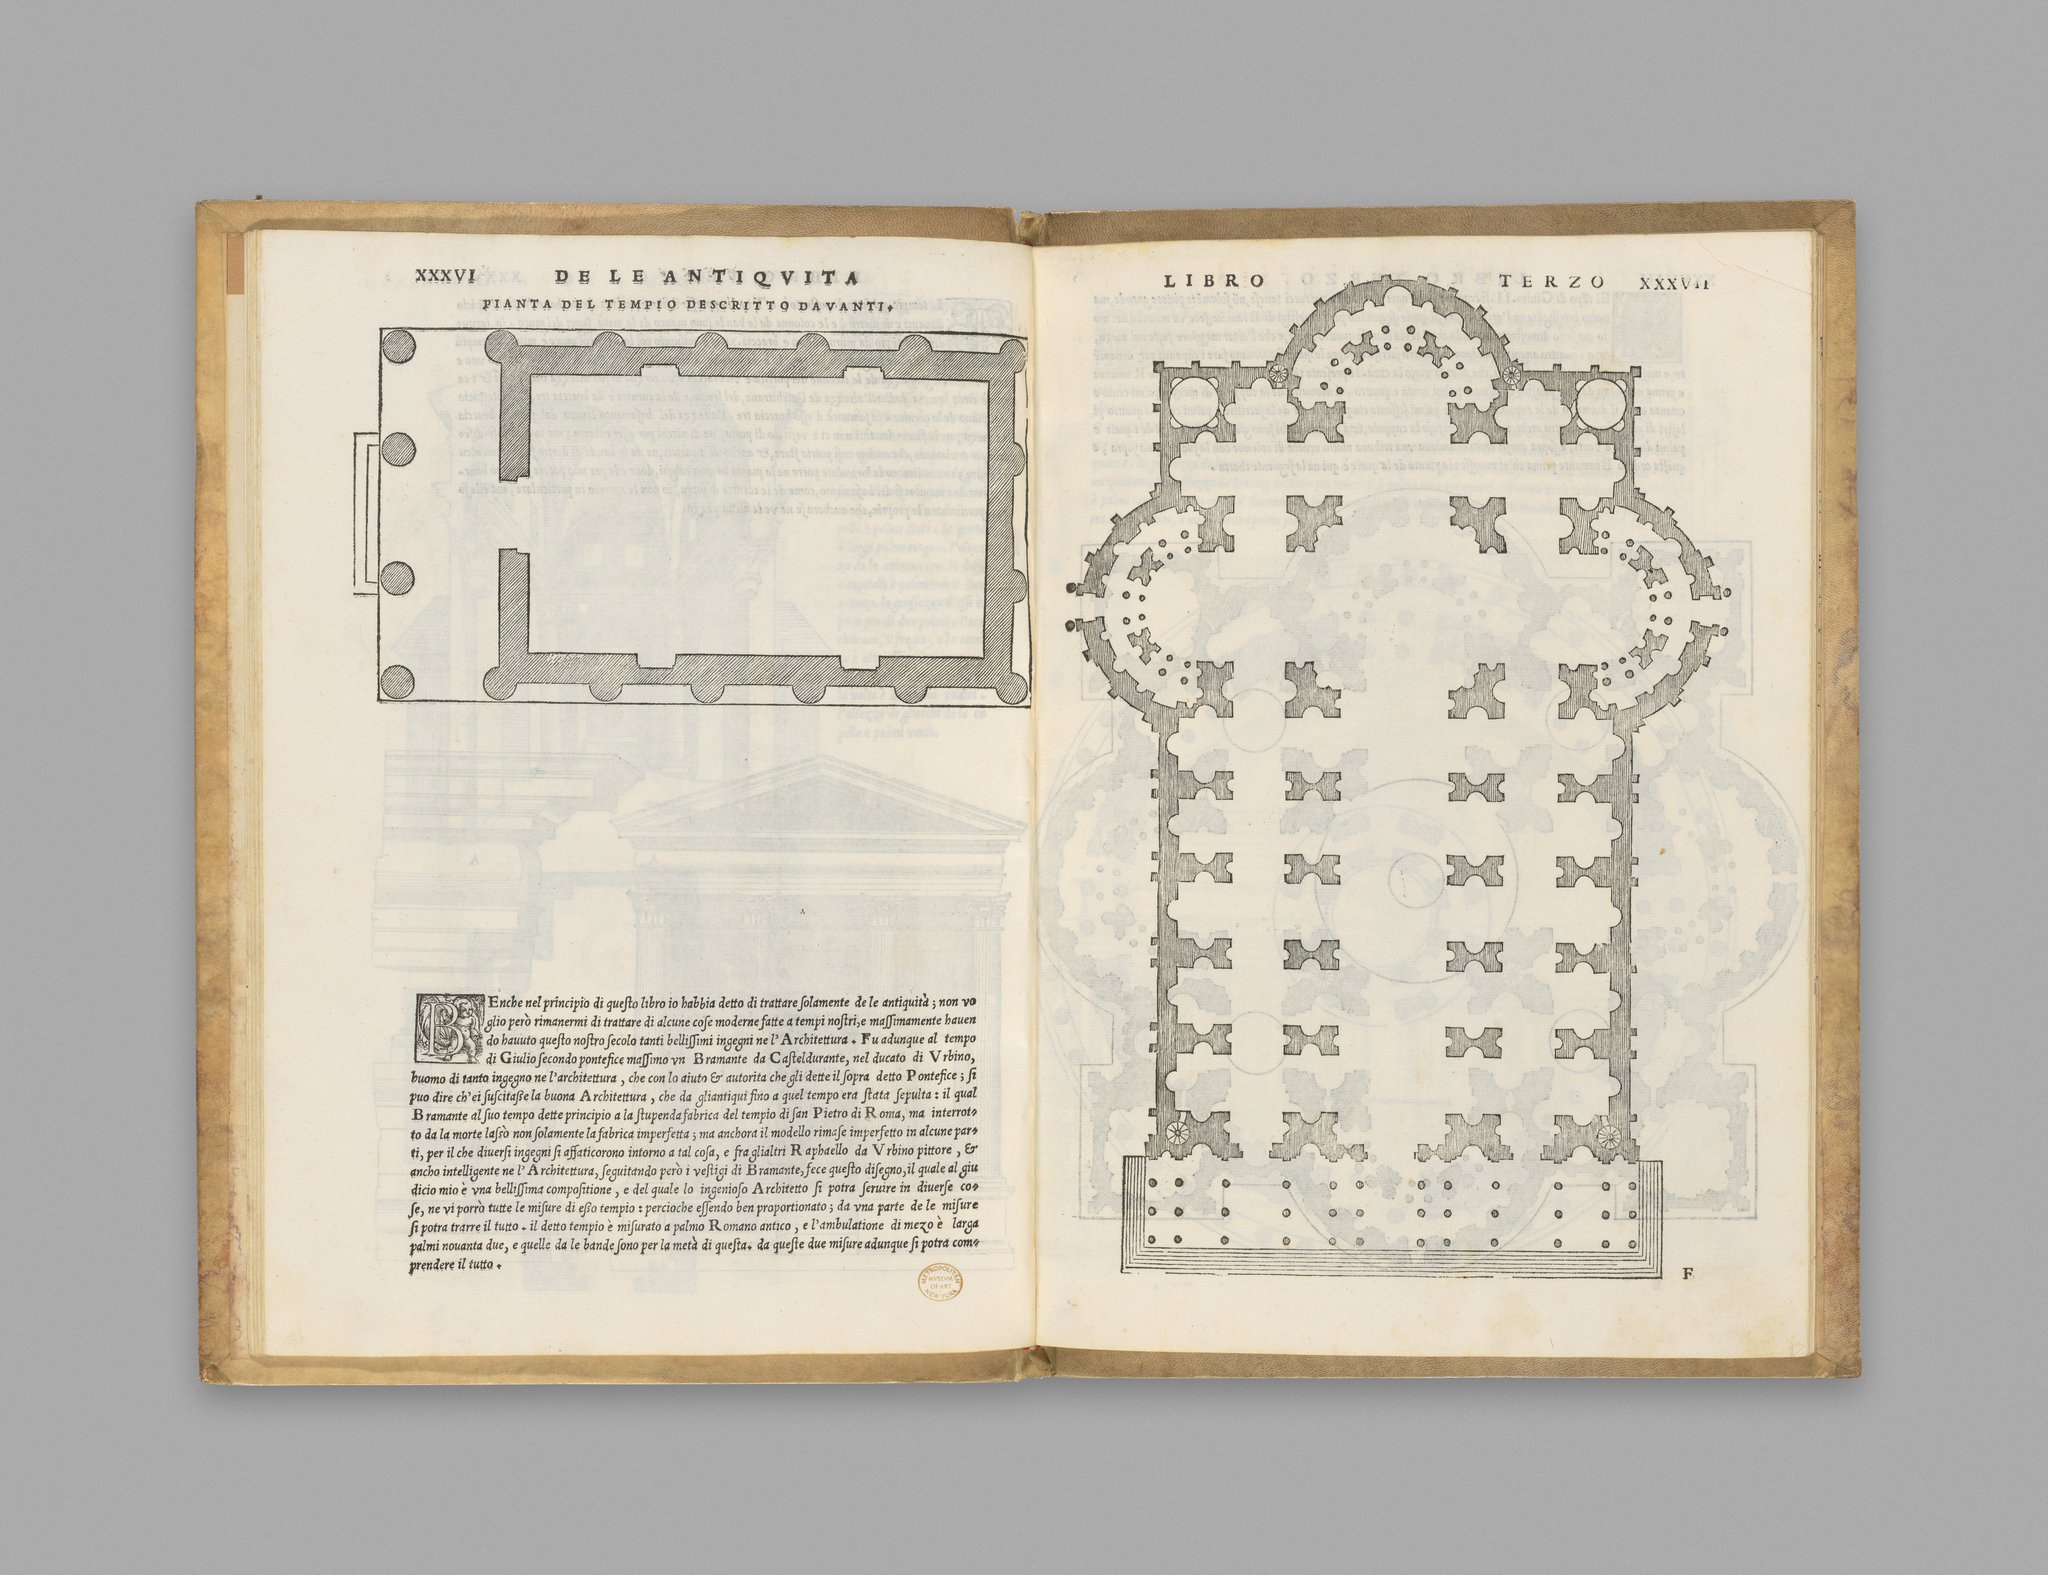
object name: book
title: Il terzo libro di Sabastiano Serlio Bolognese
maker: sebastiano serlio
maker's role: author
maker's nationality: italian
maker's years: 1475-1554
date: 1540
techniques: printing, woodcut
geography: italy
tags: architecture